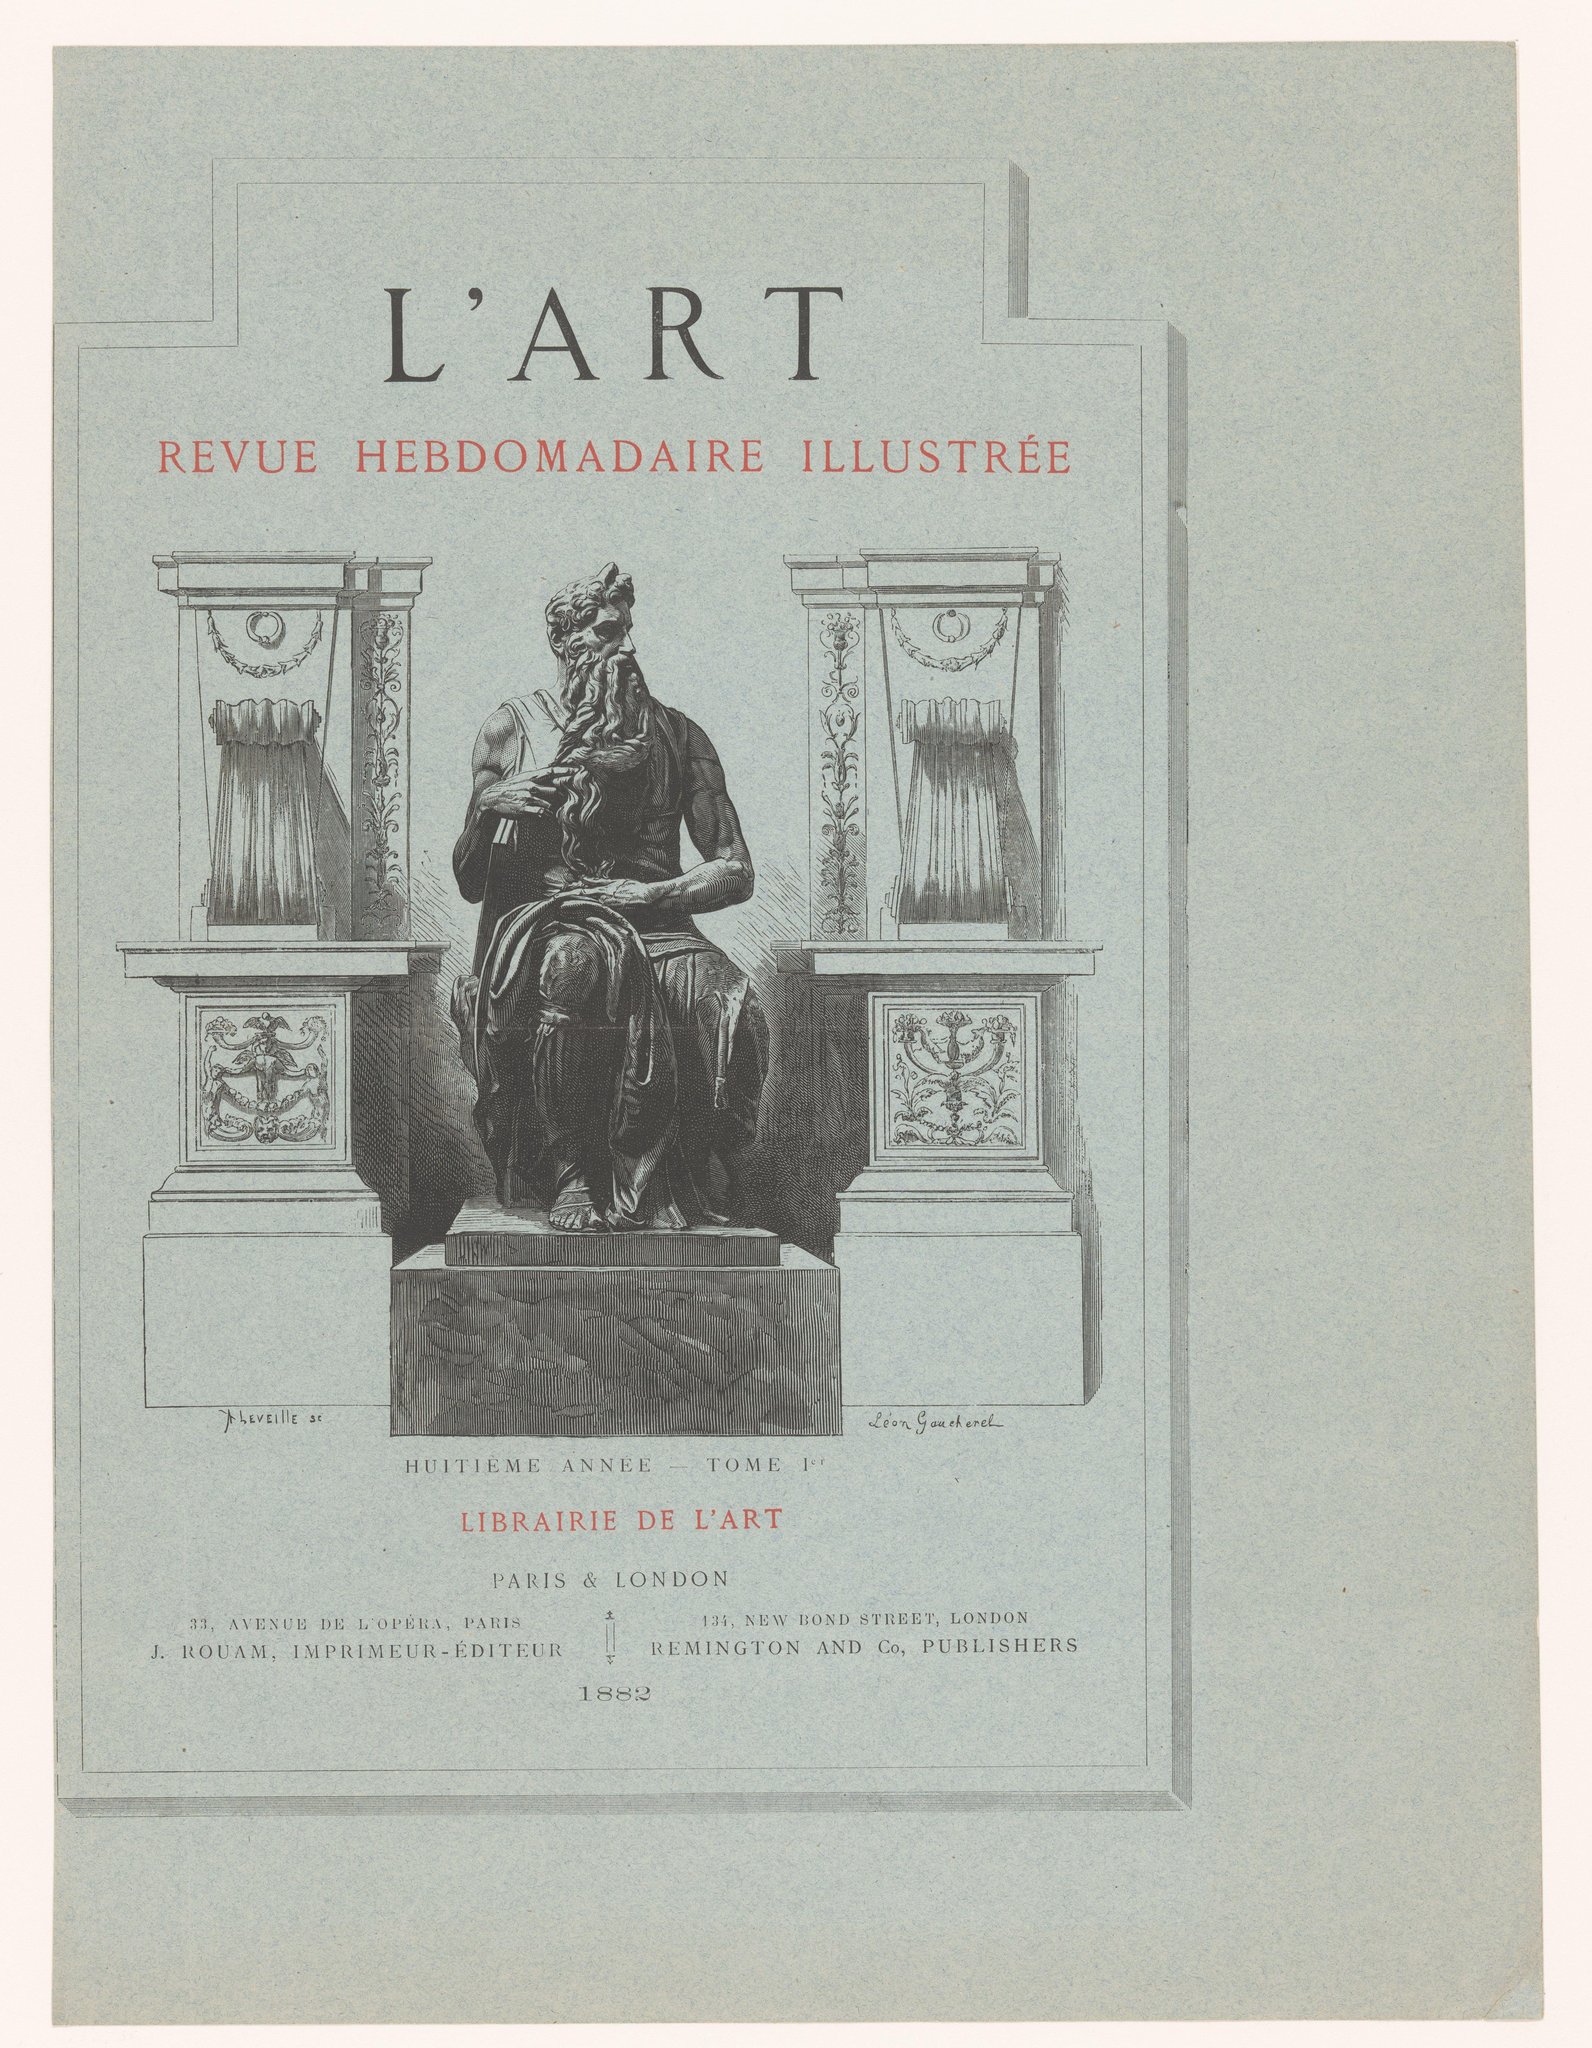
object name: print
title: Titelpagina voor: Librairie de l'Art, L'Art Revue Hebdomadaire Illustrée, 1882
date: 1882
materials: paper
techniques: letterpress printing, engraving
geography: london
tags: moses (not in biblical context); possible attributes: rays of light or horns on his head, rod, tables of the law, sculpture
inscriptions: collector's mark: Lugt 2233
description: Titelpagina voor: Librairie de l'Art. L'Art Revue Hebdomadaire Illustrée. Parijs: J. Rouam, 1882, achtste jaargang, eerste deel.